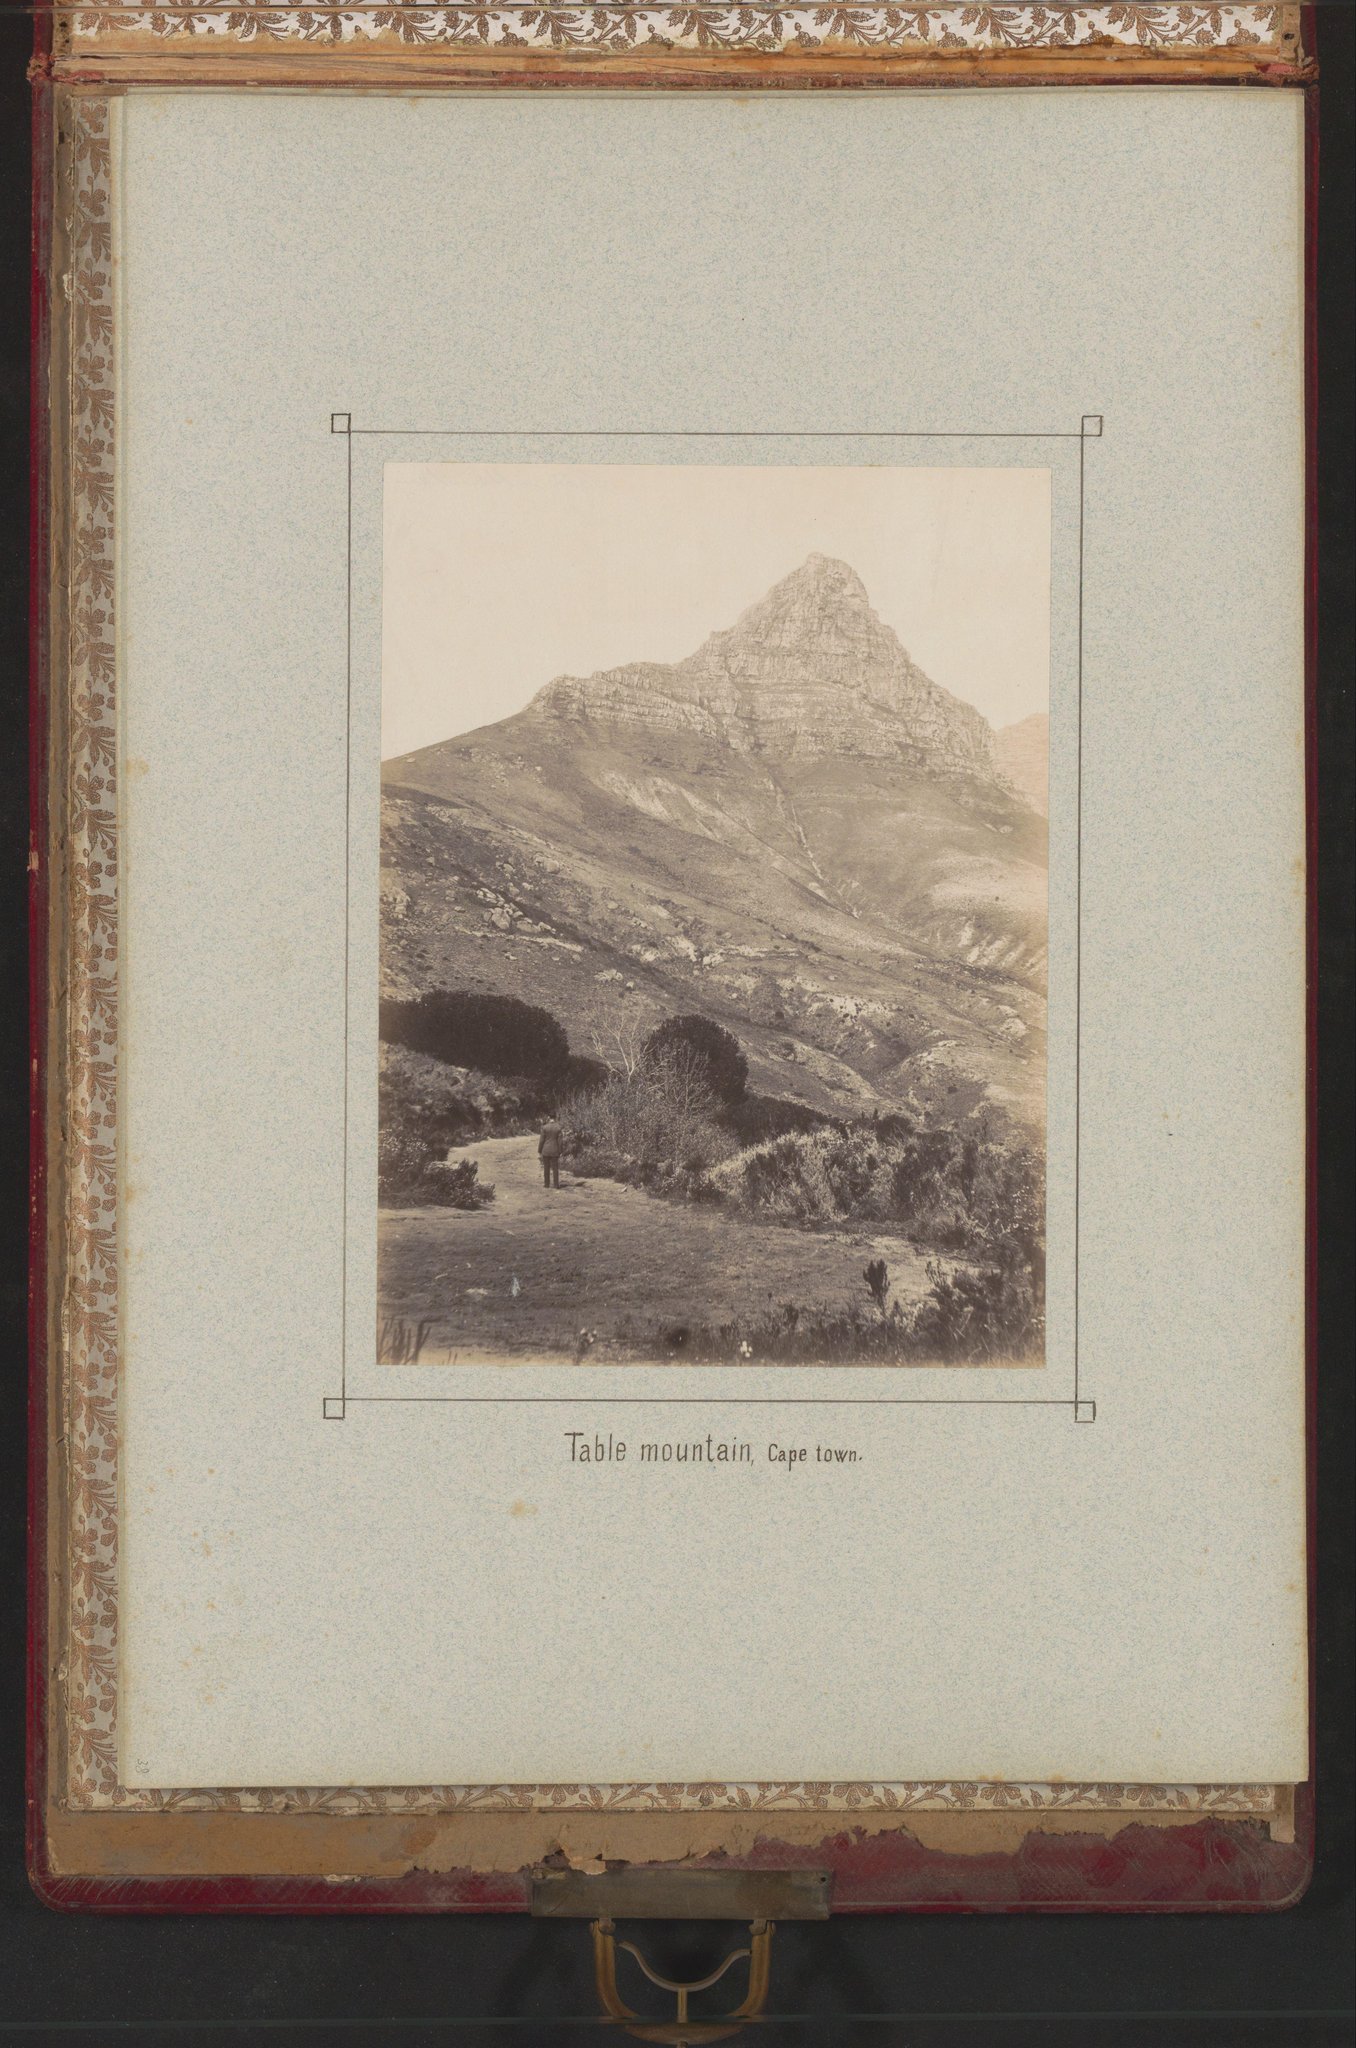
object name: photograph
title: Table mountain, Cape town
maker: Anonymous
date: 1880-1900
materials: photographic support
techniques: albumen print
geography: cape town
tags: mountain-top, peak (+ landscape with figures, staffage)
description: Onderdeel van Reisalbum met foto's van Zuid-Afrika, Madeira, Portugal, Frankrijk en Duitsland.